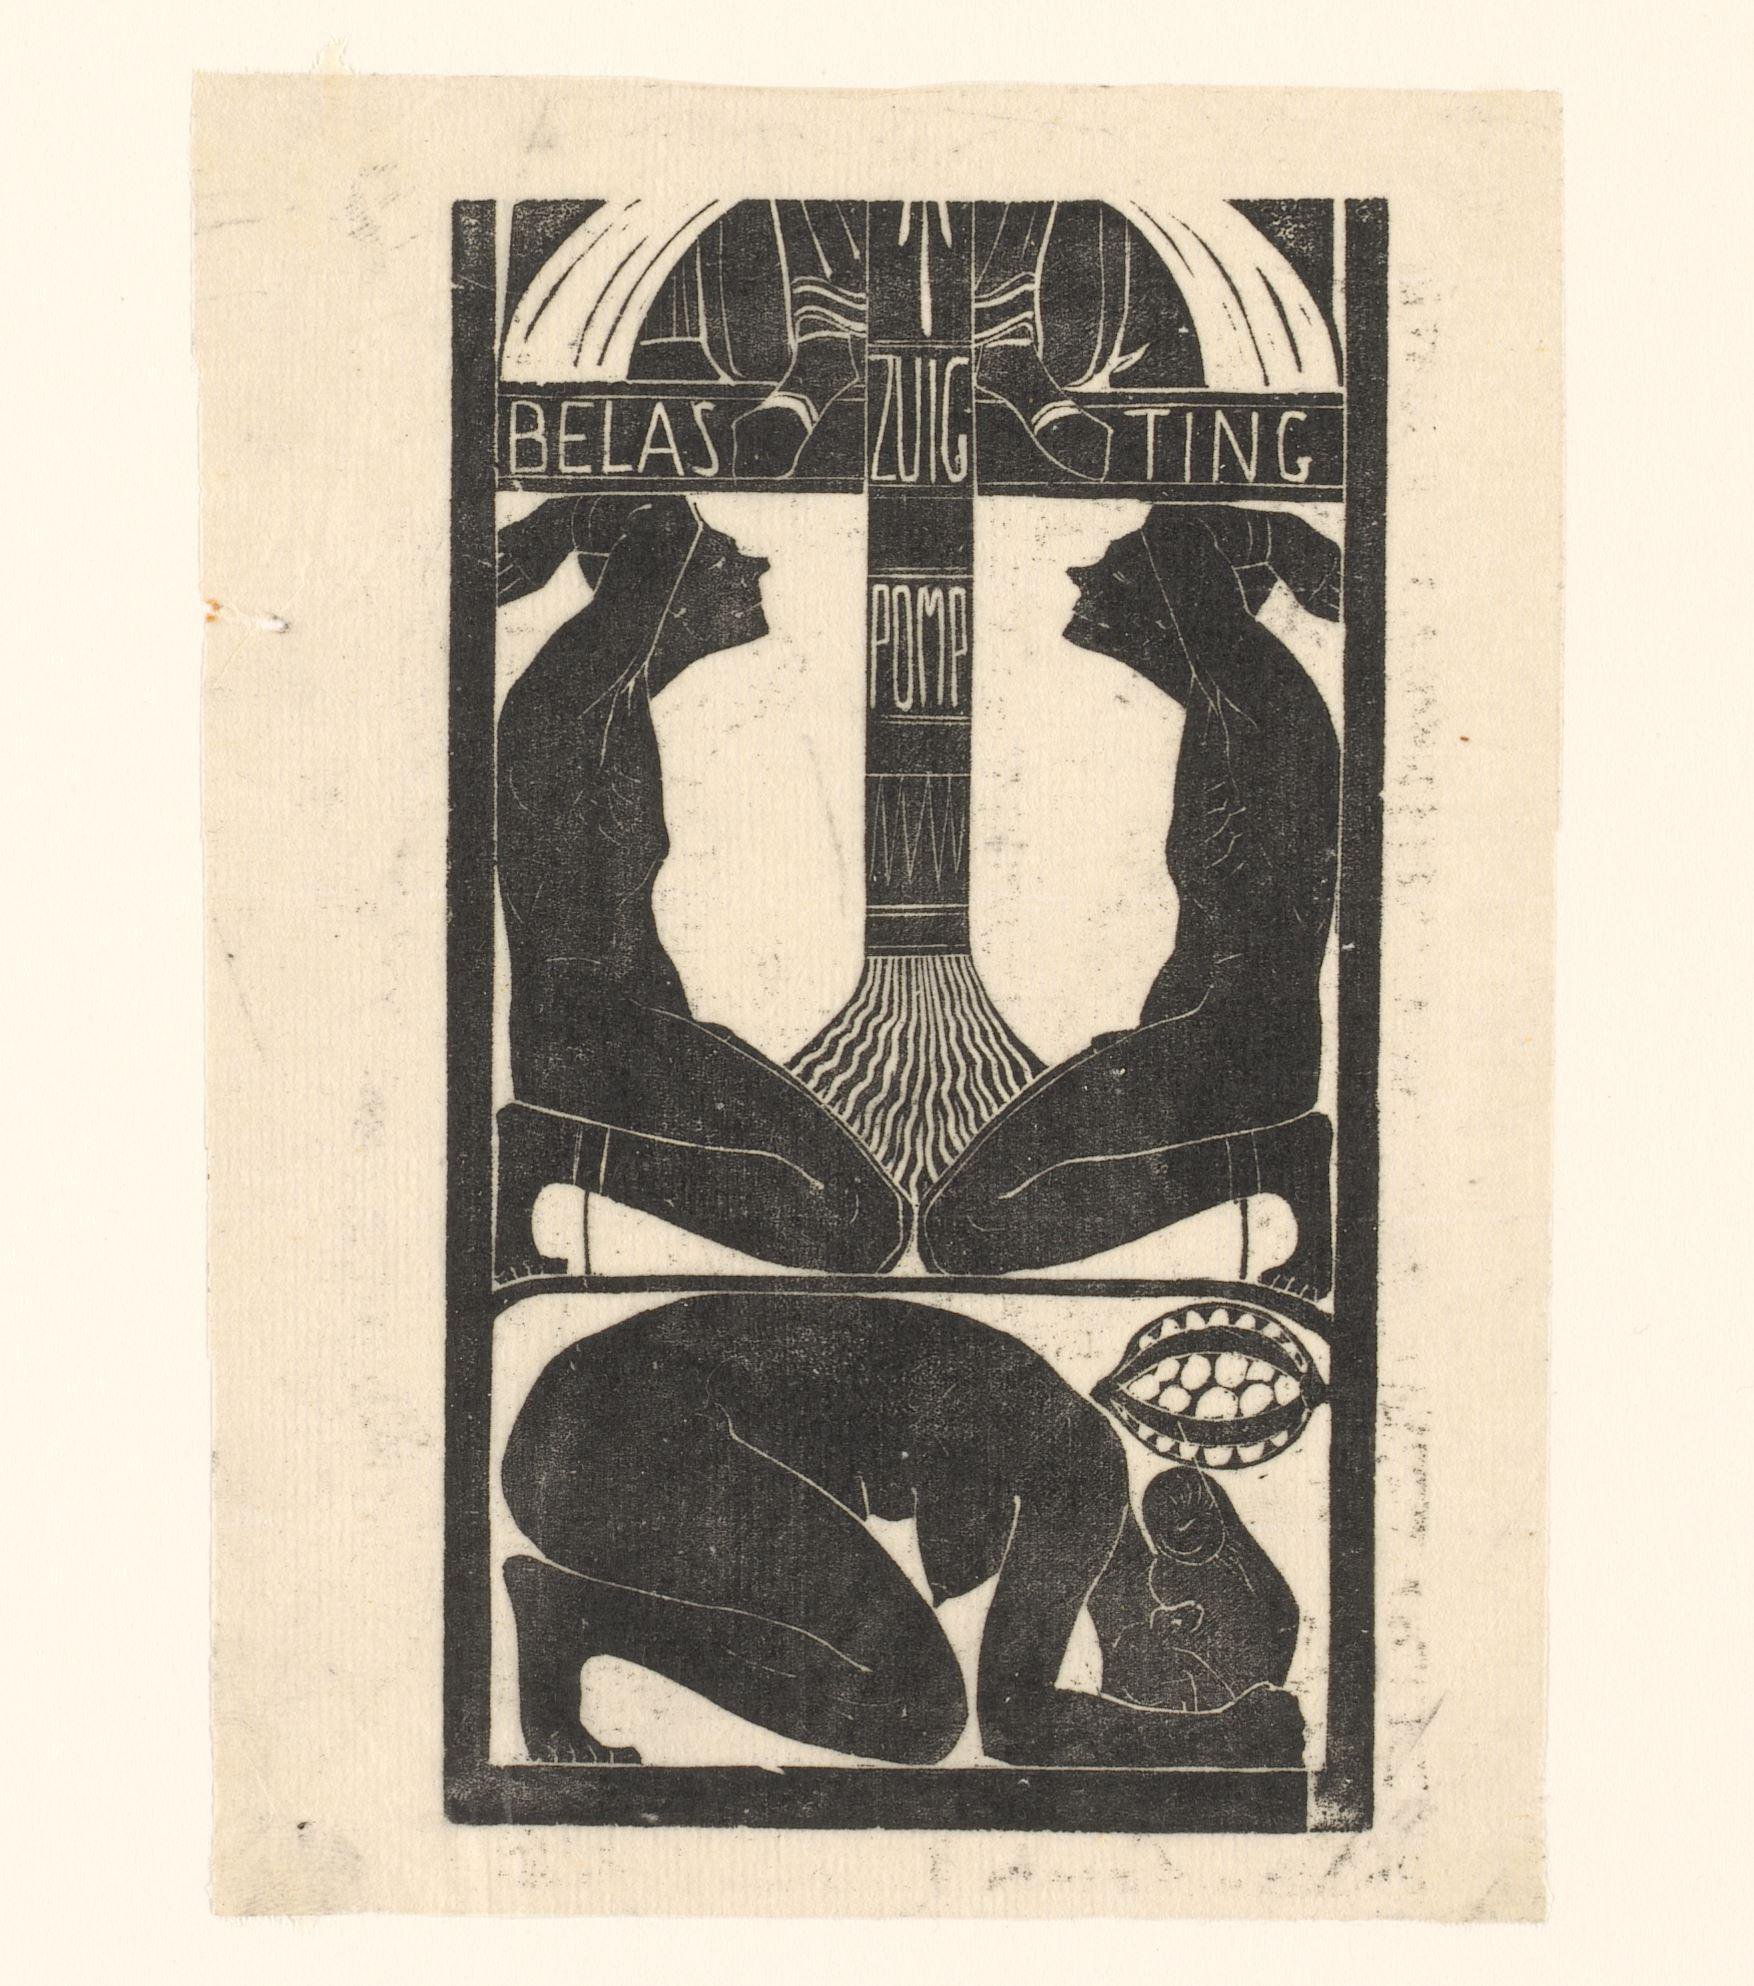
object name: print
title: Onderste helft van 'Belastingzuigpomp'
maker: karel petrus cornelis de bazel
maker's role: draughtsman, print maker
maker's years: 1869-1923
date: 1894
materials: paper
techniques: woodcut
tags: (showing oneself) undressed, quasi-nude, kneeling figure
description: Enkel de onderste helft van de prent. Als geheel is deze prent gebruikt voor: Licht en waarheid. Orgaan van de Vereeniging 'Wie denkt overwint', 22 september 1894.